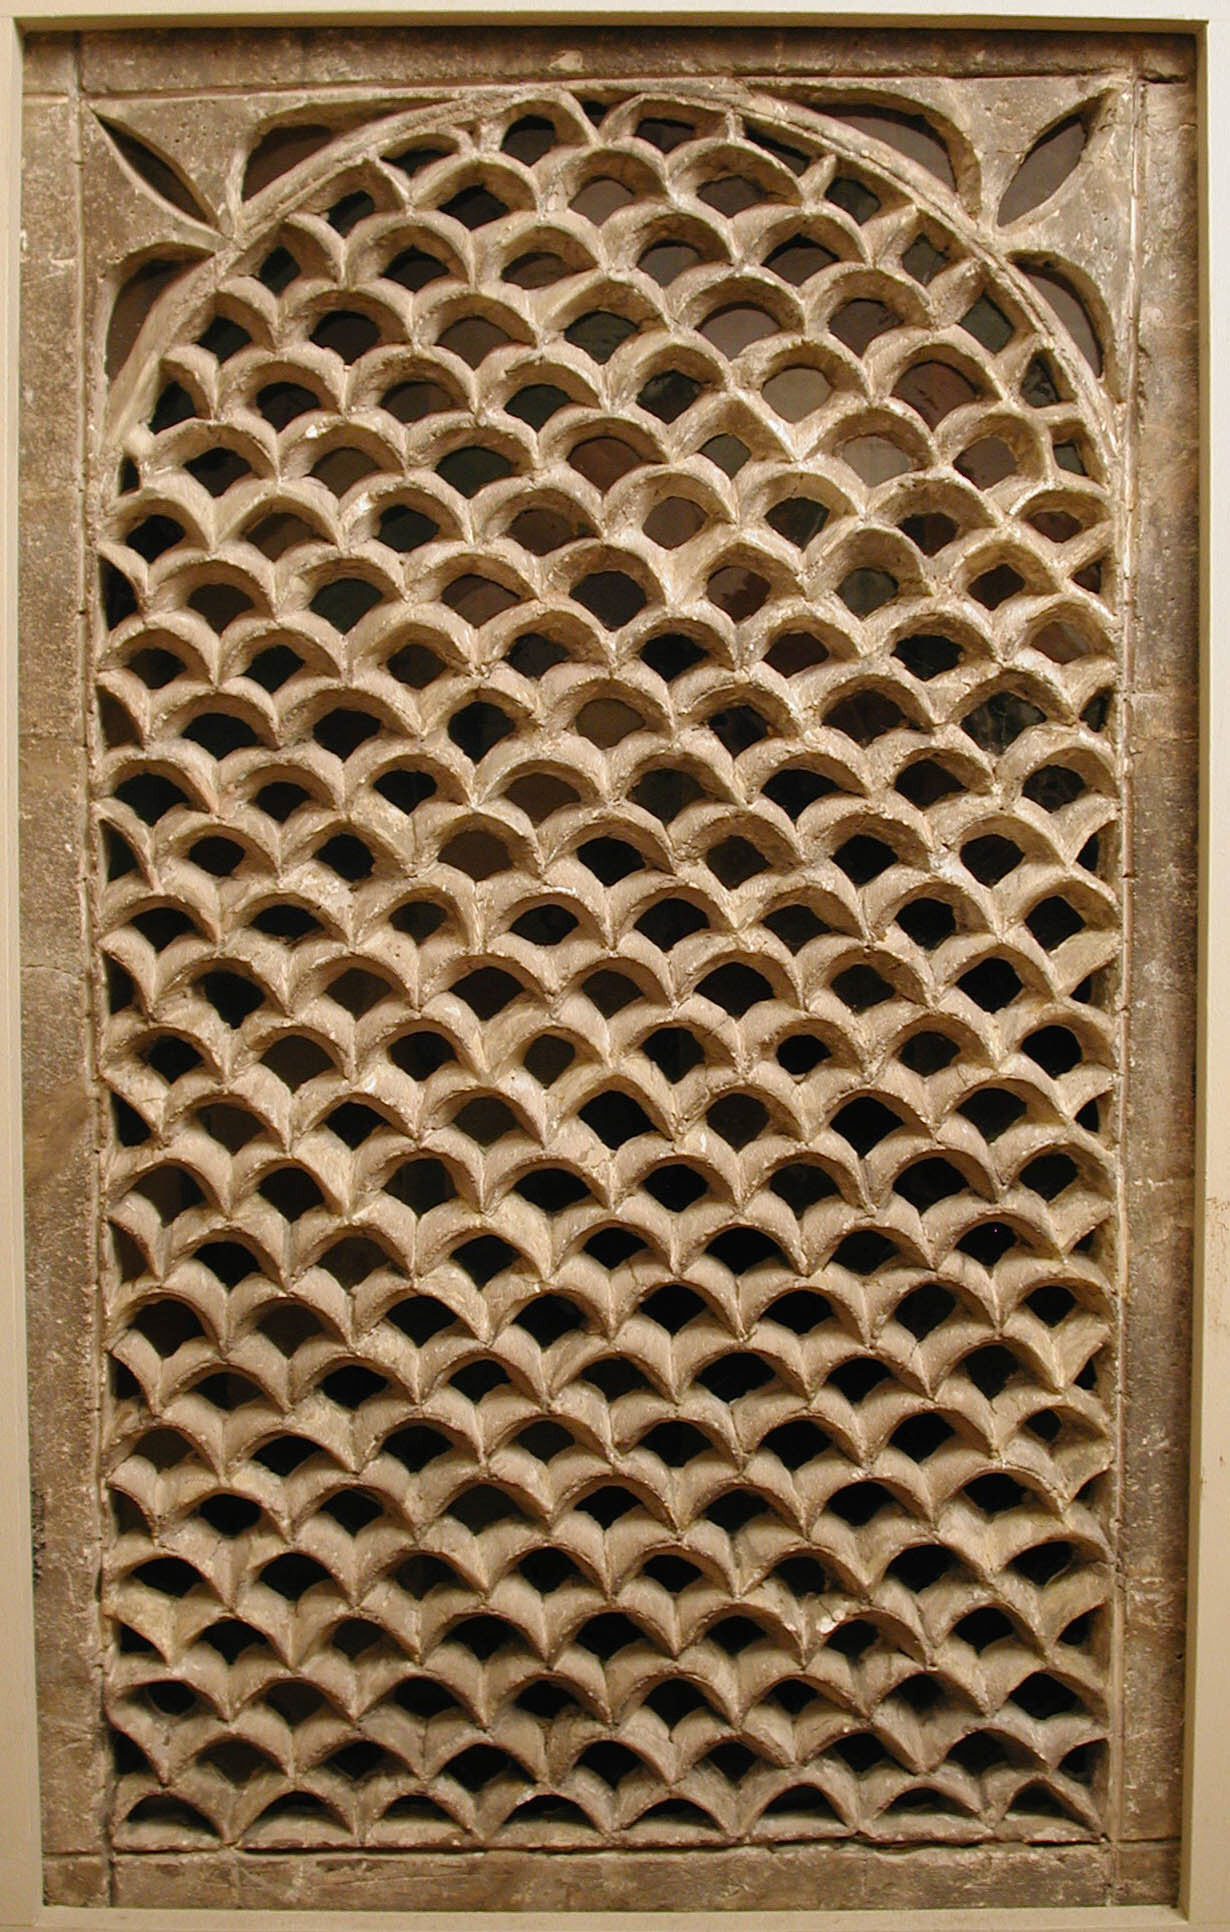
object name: window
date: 1601-1700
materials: gypsum, glass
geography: egypt or syria